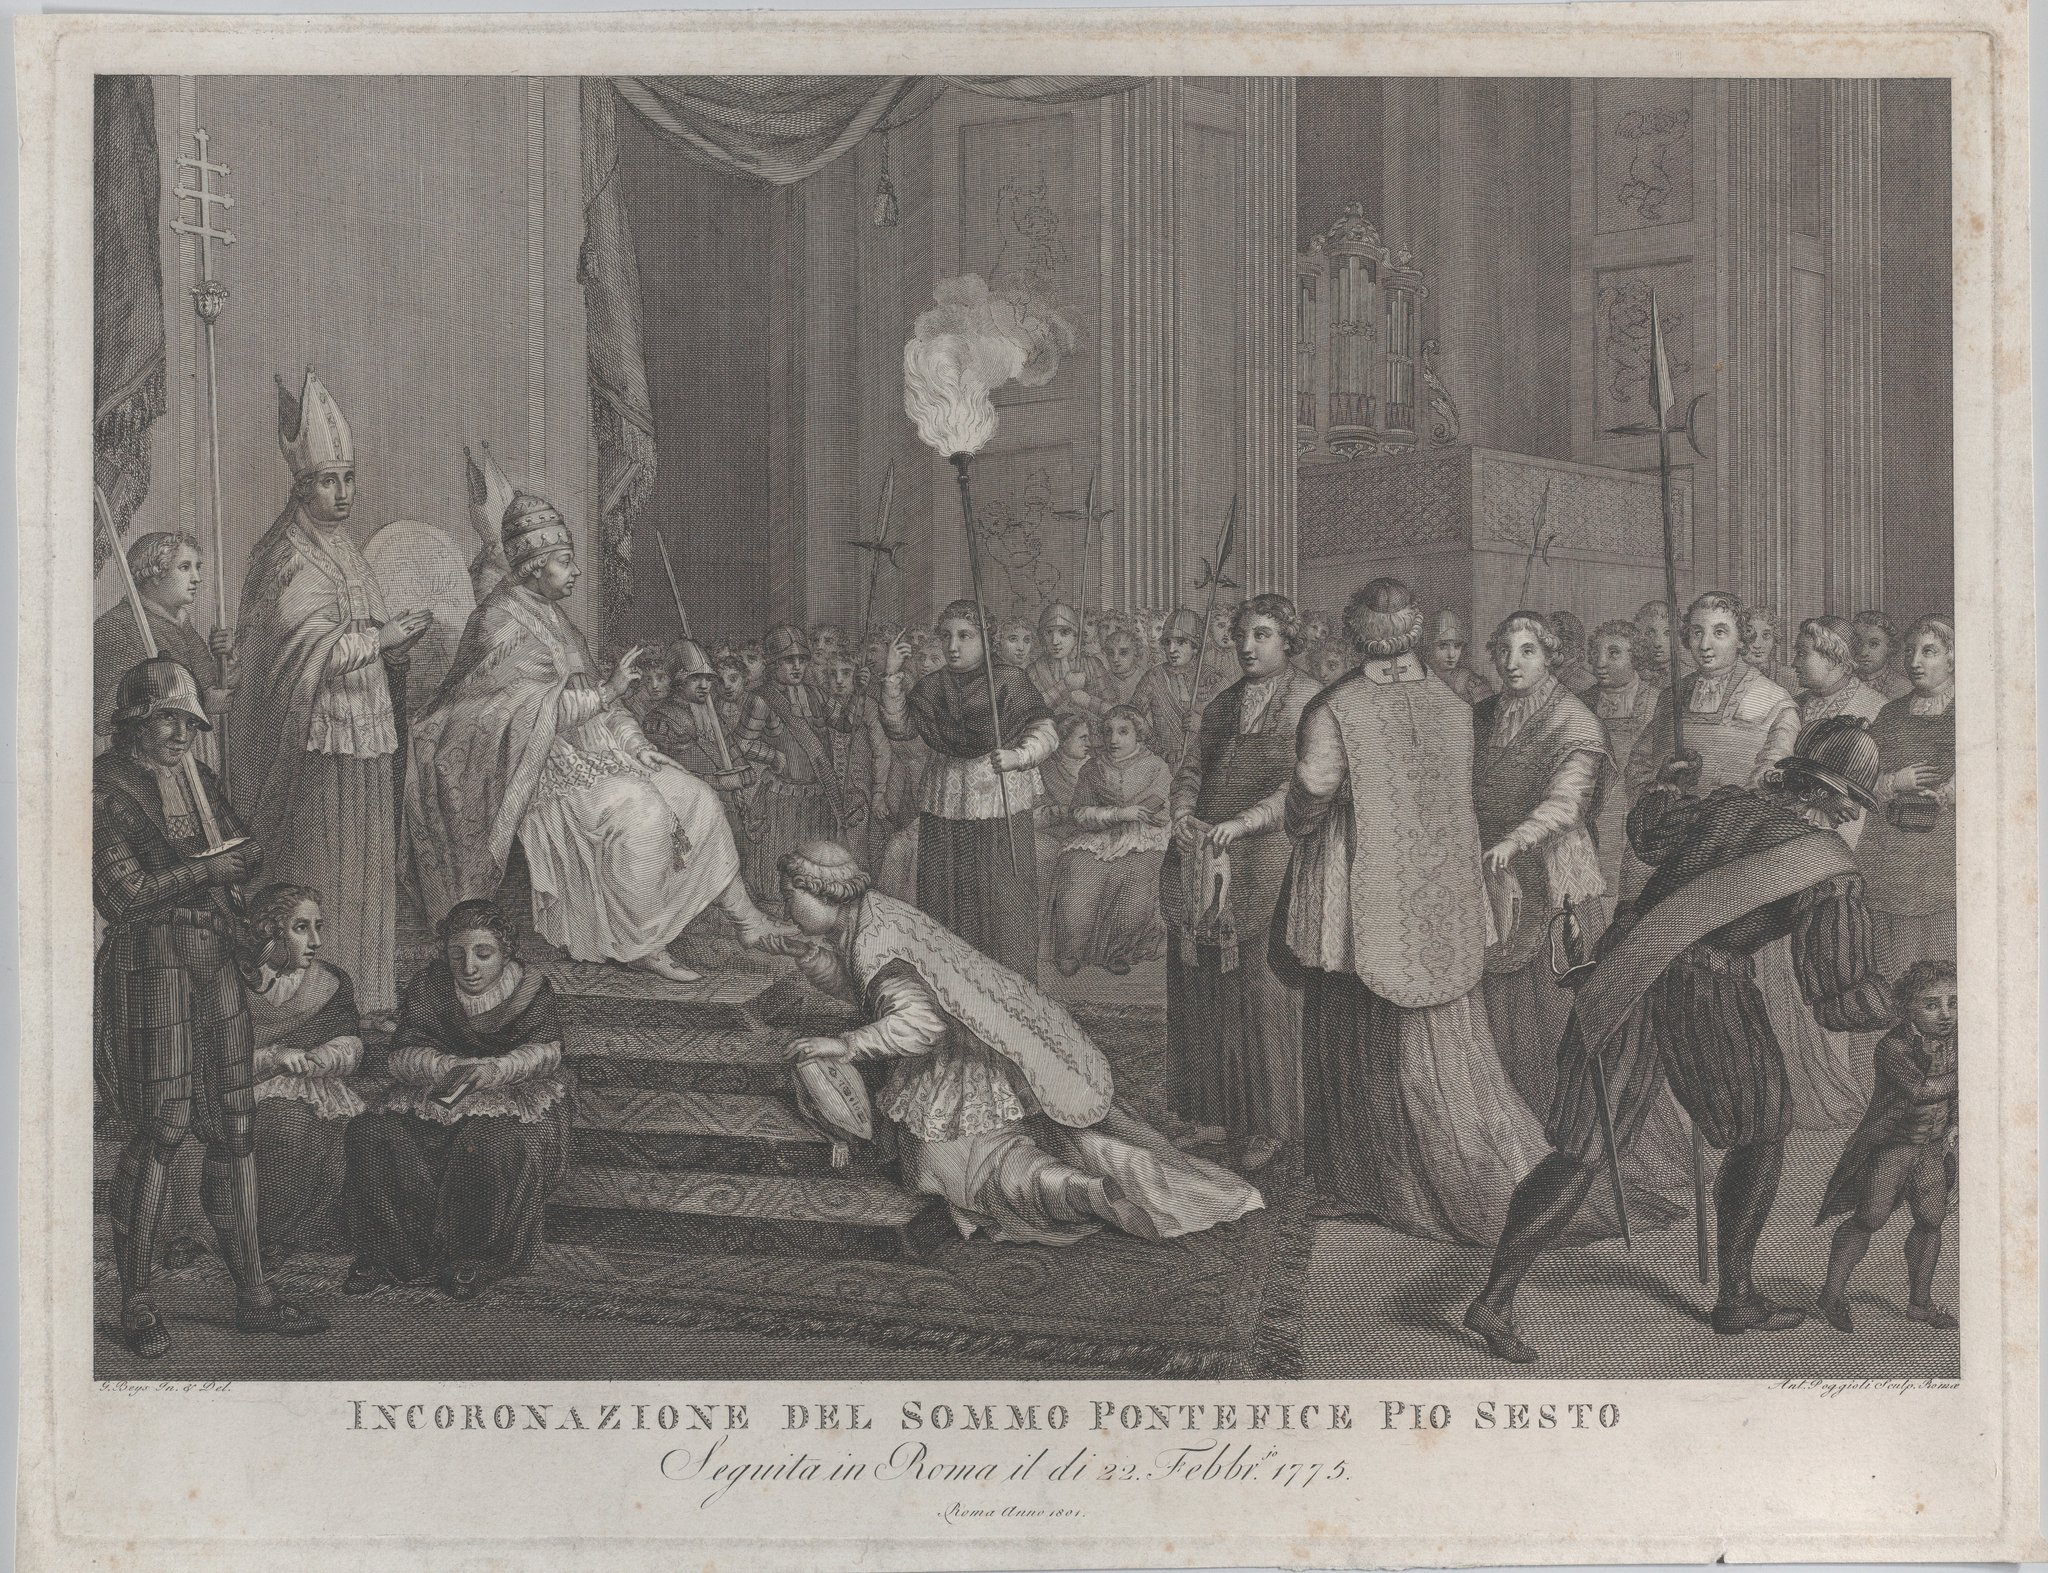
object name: print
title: Coronation of Pope Pius VI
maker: antonio poggioli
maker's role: artist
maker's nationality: italian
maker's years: 1700-1801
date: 1801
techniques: engraving